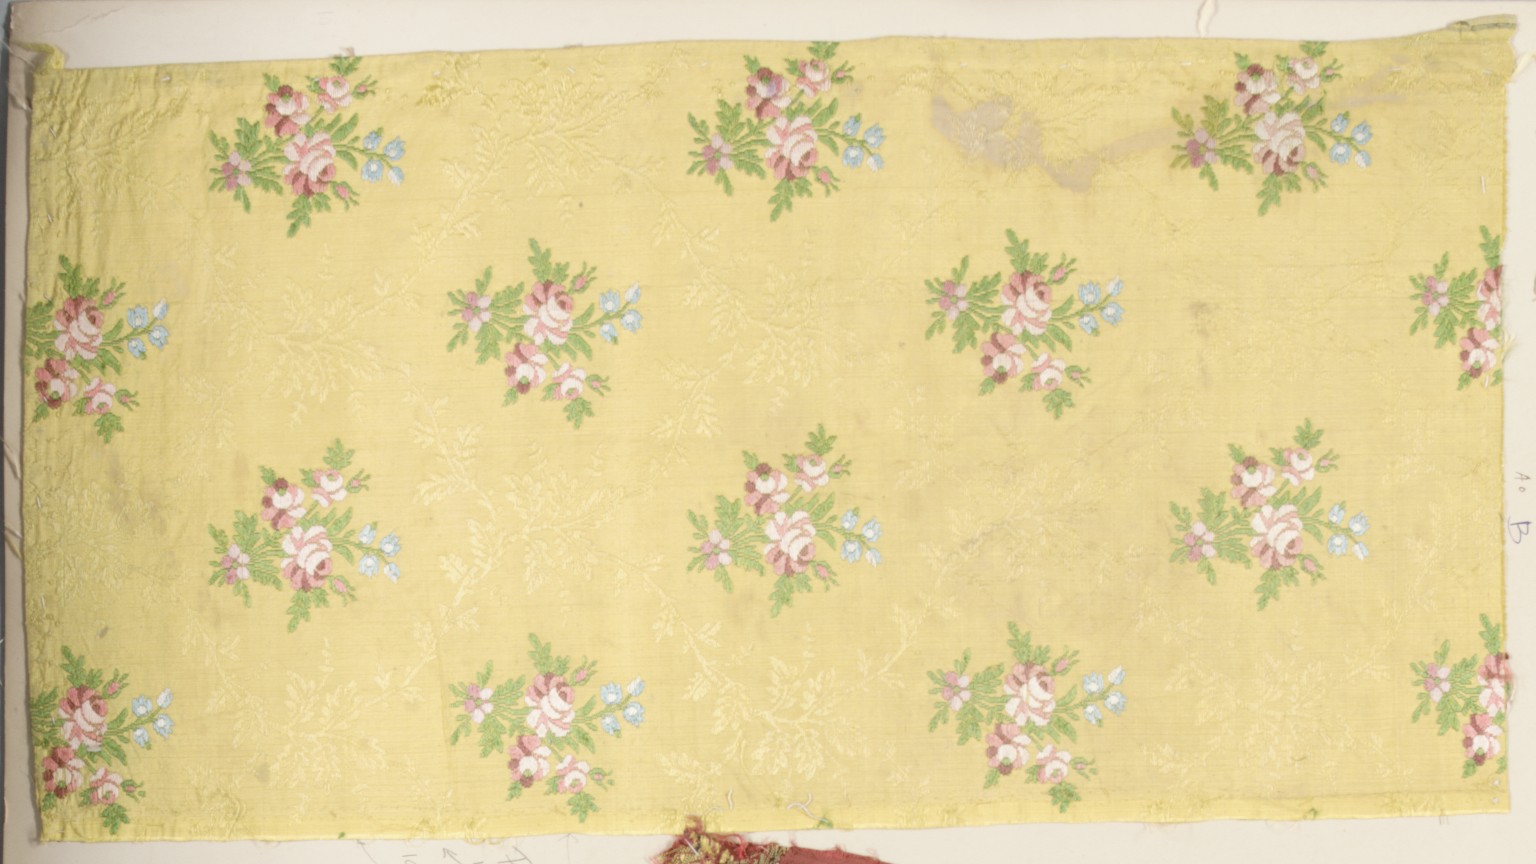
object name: fragment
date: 1701-1800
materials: silk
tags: flowers,leaves